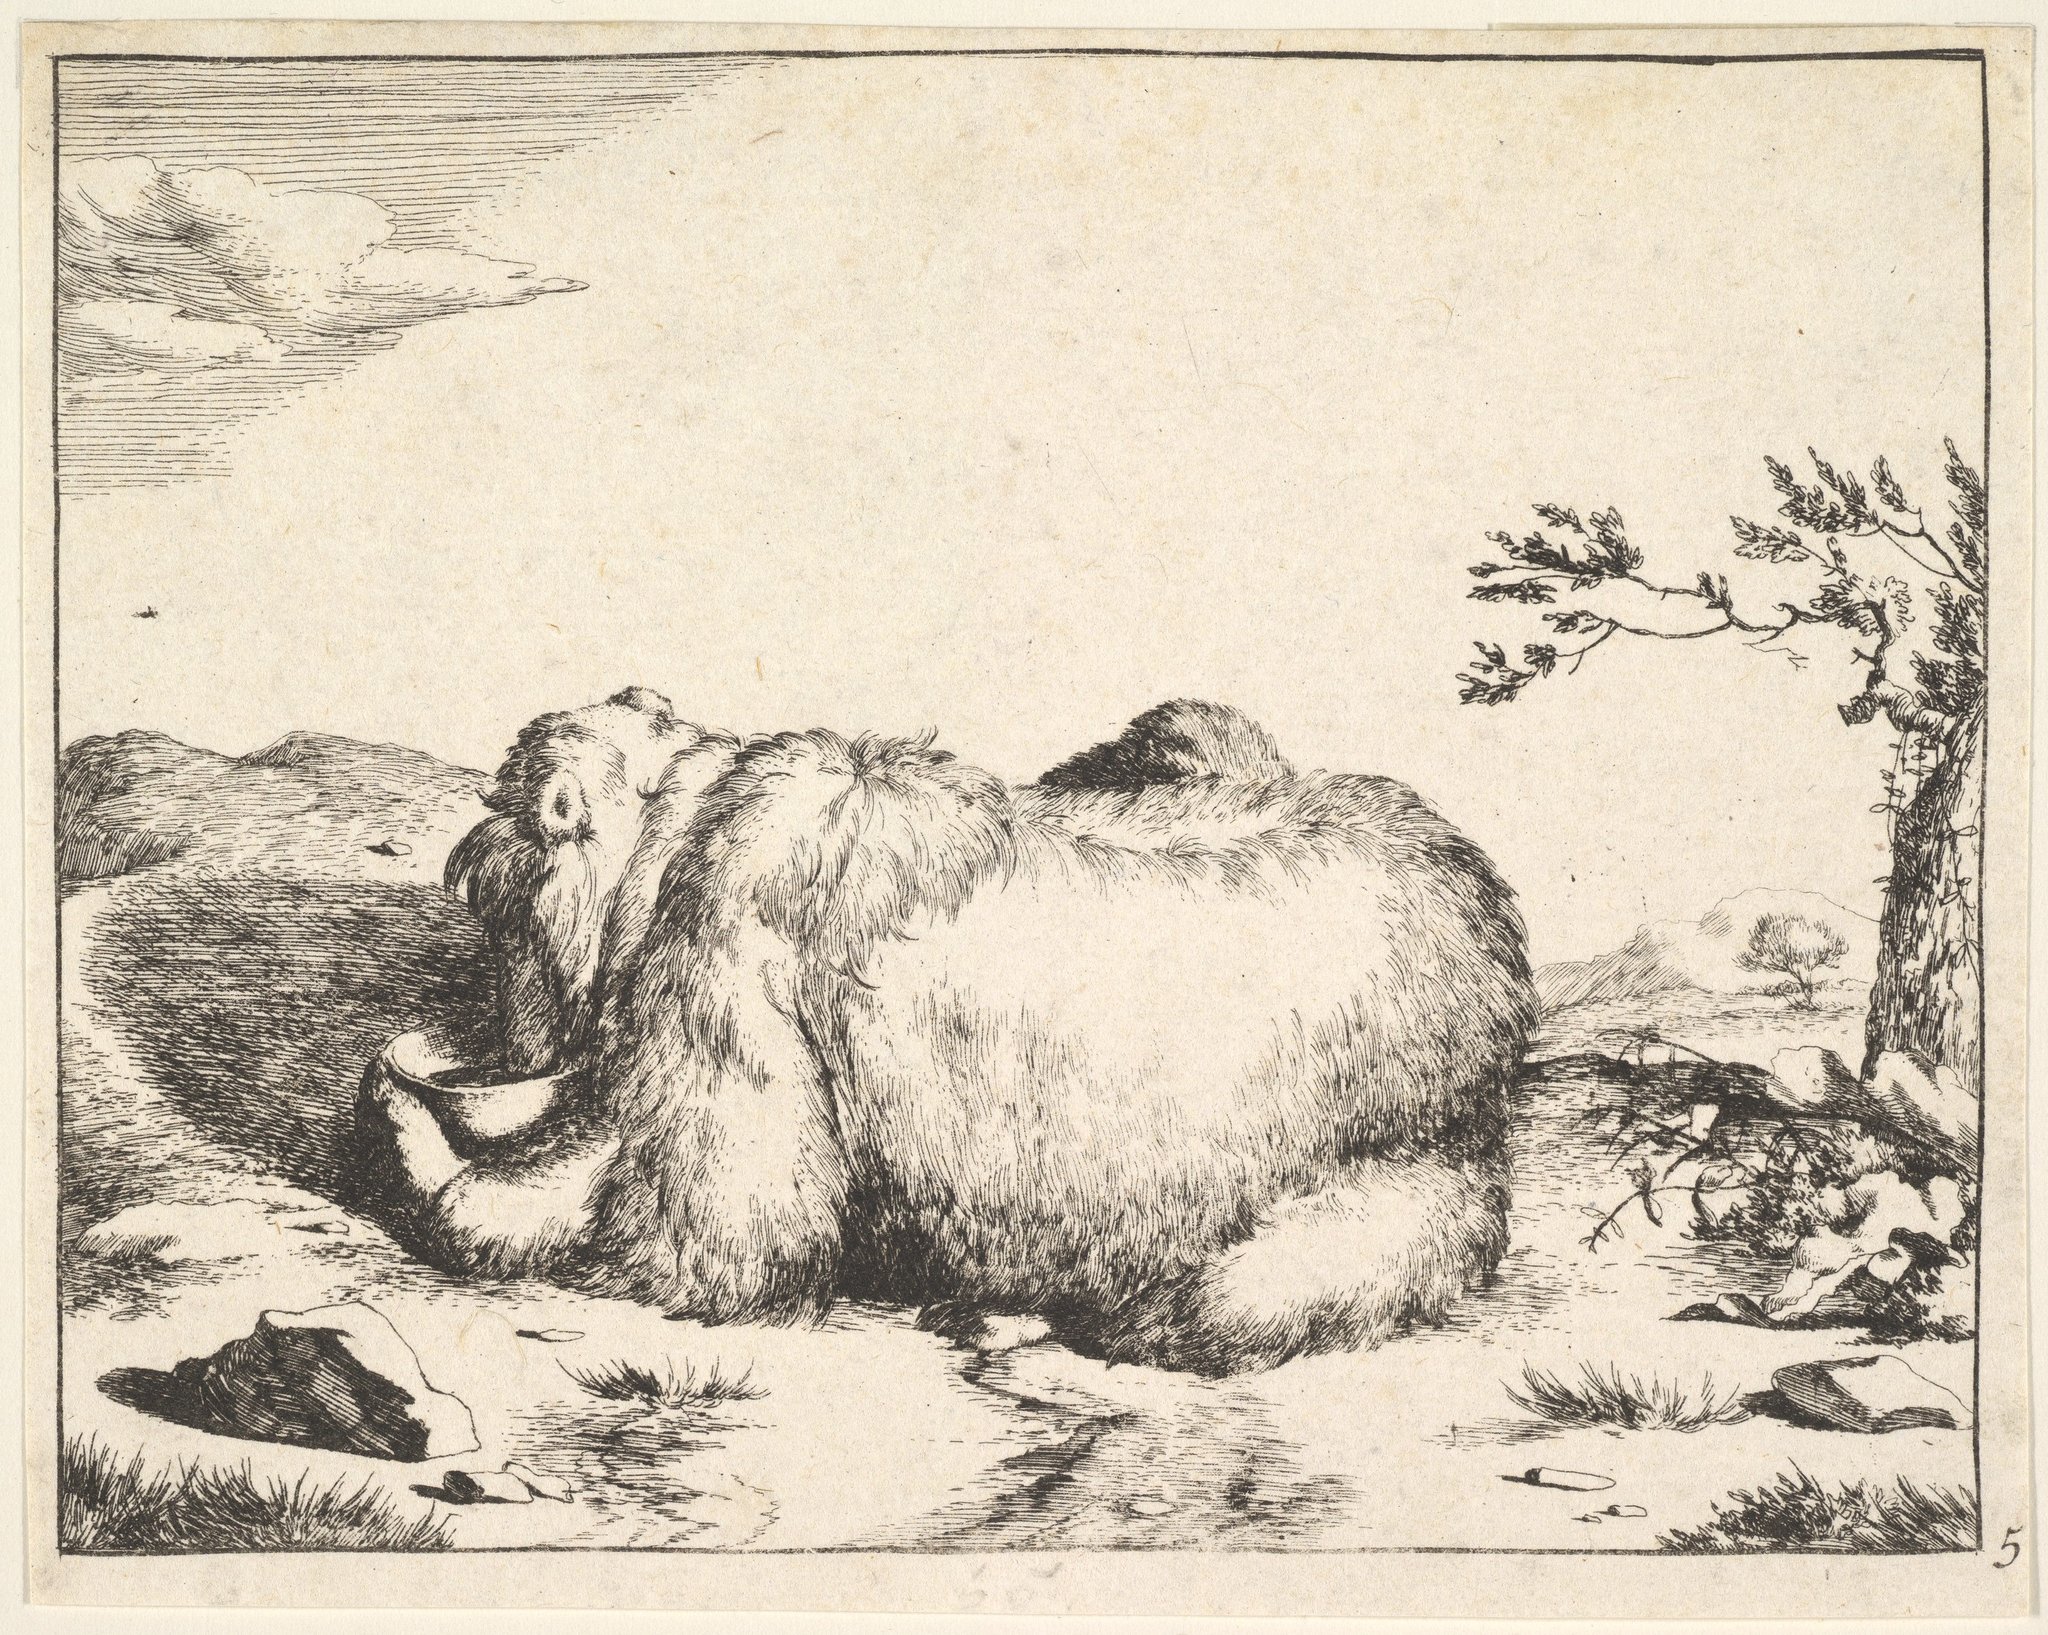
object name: print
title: Plate from "The Set of The Bears"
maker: marcus de bye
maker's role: artist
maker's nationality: dutch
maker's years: 1639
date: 1664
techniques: etching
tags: bears